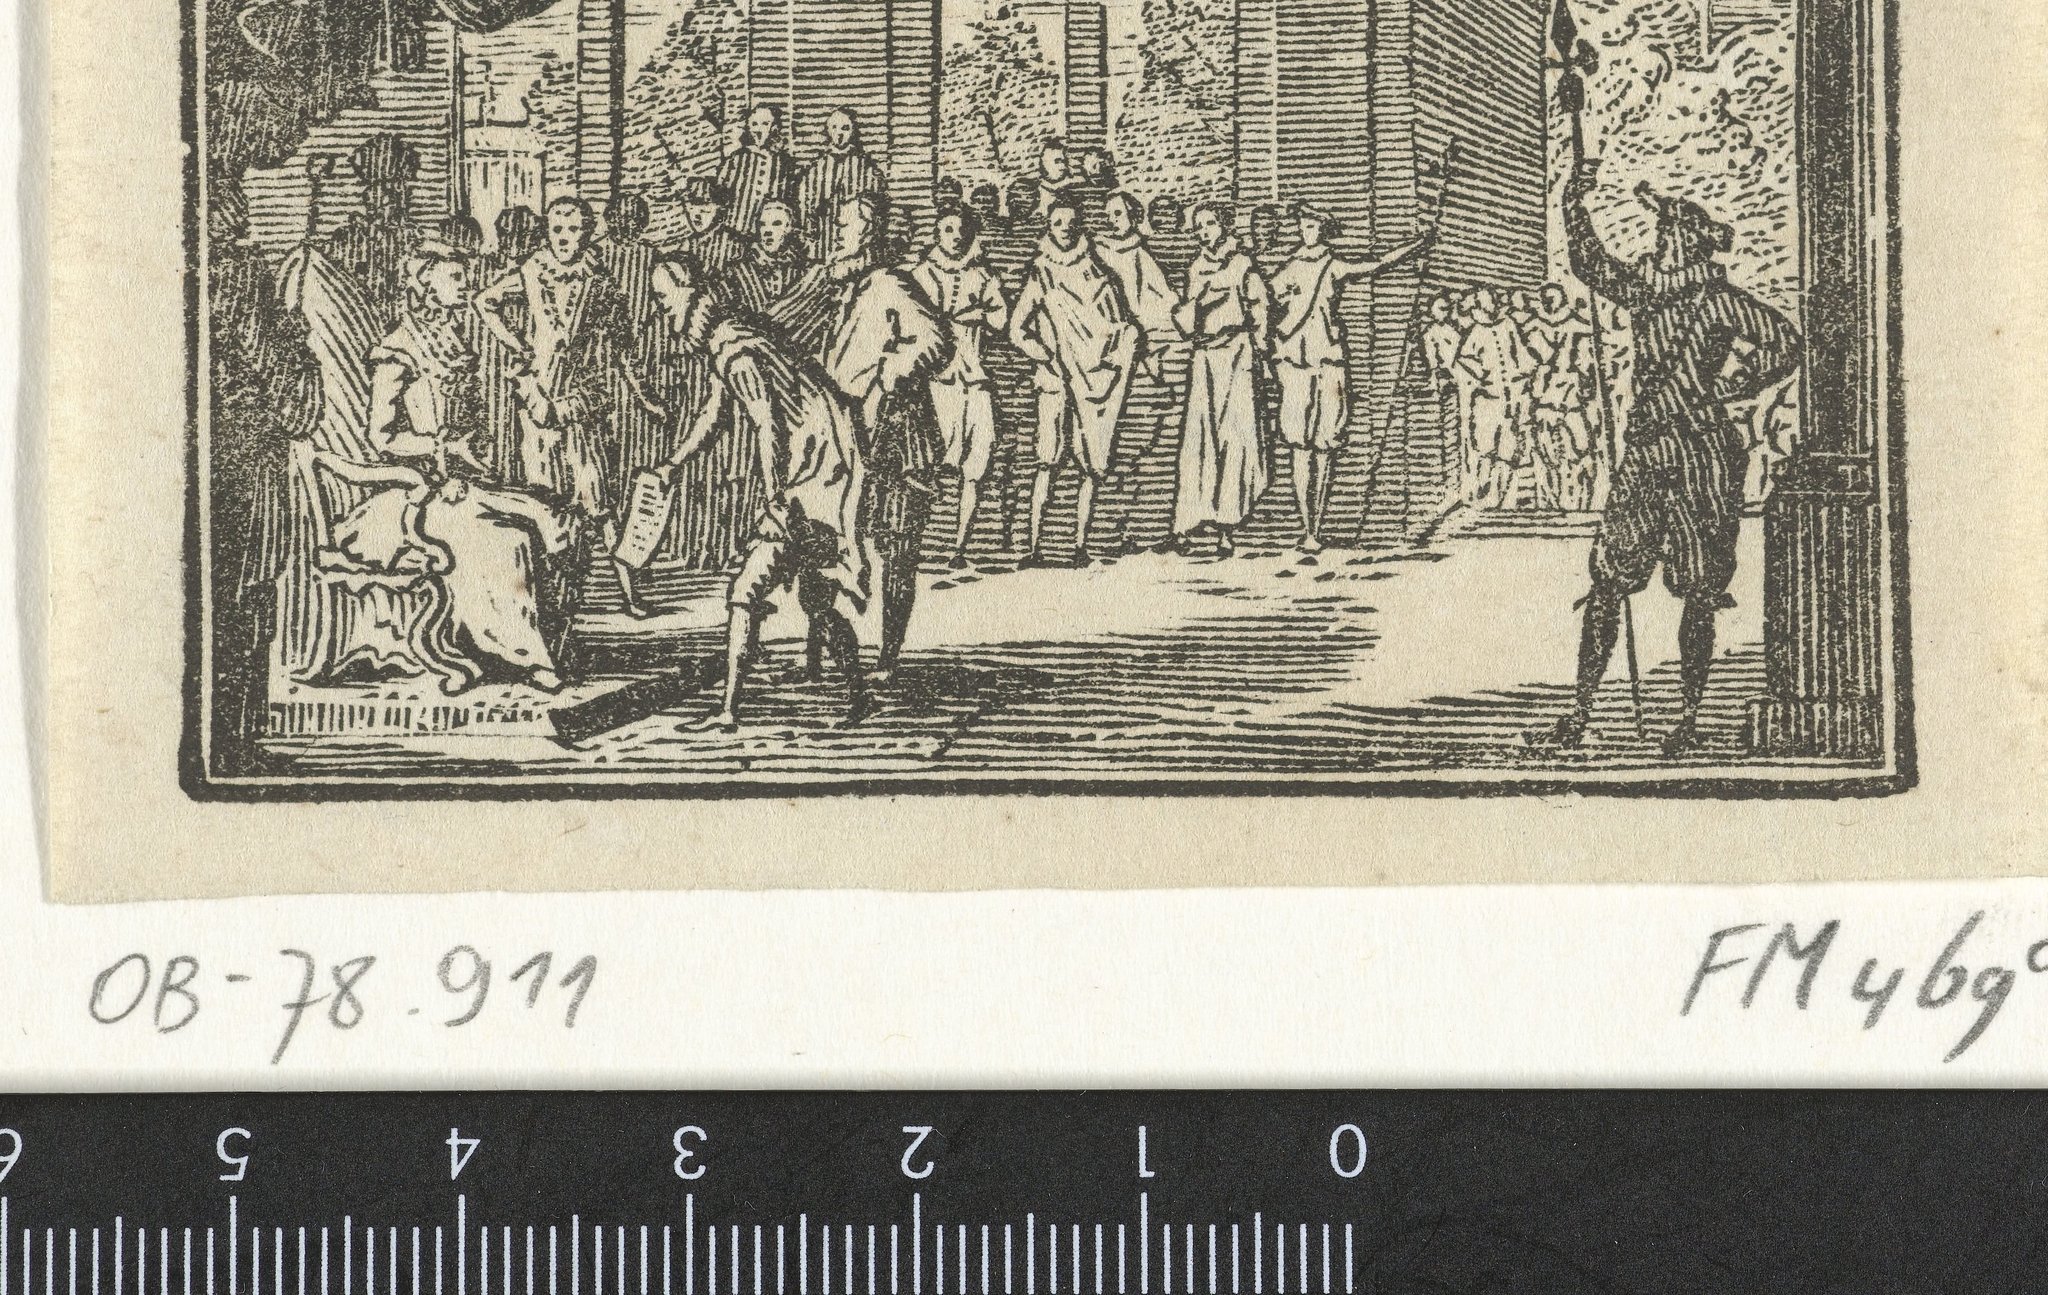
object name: history print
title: Het aanbieden van het Smeekschrift aan de hertogin van Parma, 1566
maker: Anonymous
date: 1750-1899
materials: paper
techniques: woodcut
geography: netherlands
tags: hendrik van brederode (heer van vianen), oudenaarde, ortona, landvoogd, landvoogdes der nederlanden margaretha van parma, paleis op de koudenberg, smeekschrift der edelen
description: Het aanbieden van het Smeekschrift door het verbond der edelen aan de landvoogdes, de hertogin van Parma, in het paleis te Brussel 5 april 1566. Hendrik van Brederode overhandigt haar het verzoekschrift.